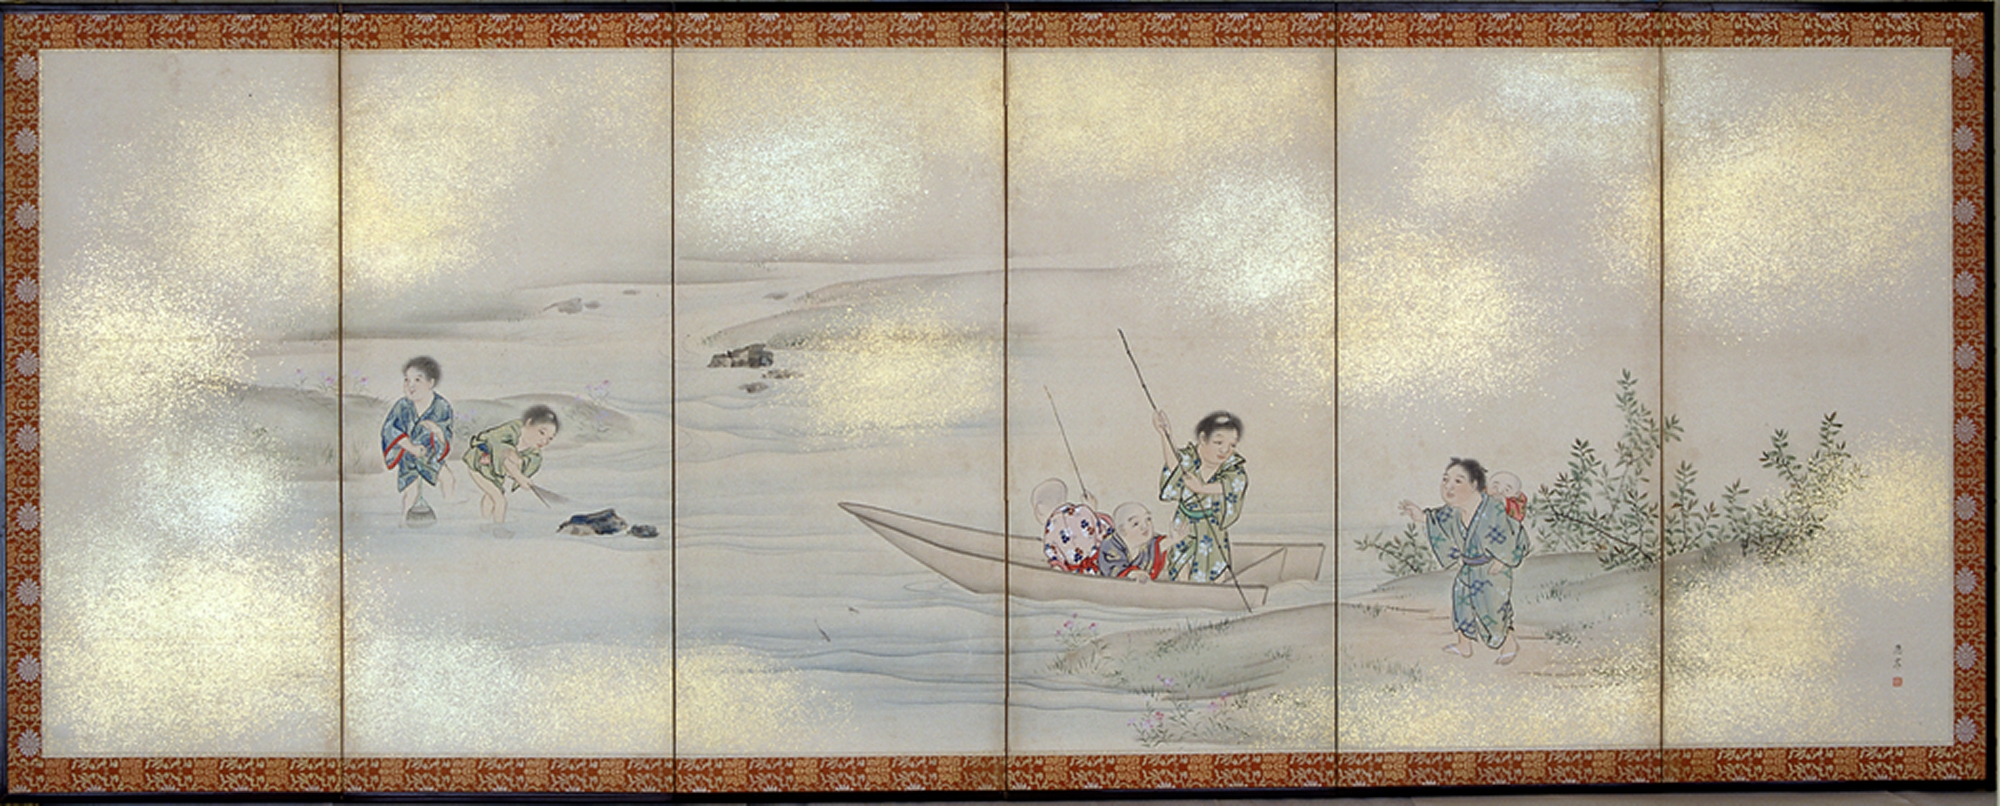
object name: screen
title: Children Playing in Summer and Winter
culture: japanese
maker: maruyama ōshin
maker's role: artist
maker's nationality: japanese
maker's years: 1790-1838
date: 1801-1833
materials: gold, ink, panel, paper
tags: boys,playing,trees,snow,boats